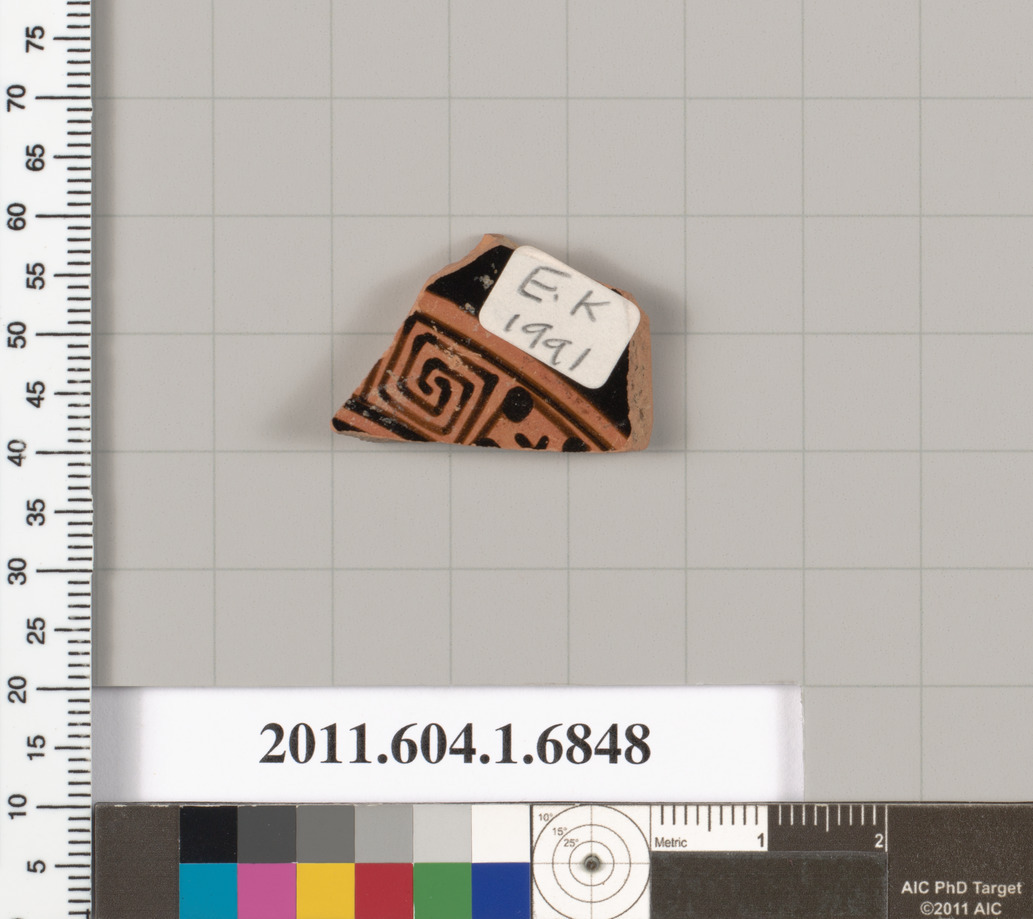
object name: kylix fragment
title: Terracotta fragment of a kylix (drinking cup)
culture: greek, attic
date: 490-470 BCE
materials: terracotta